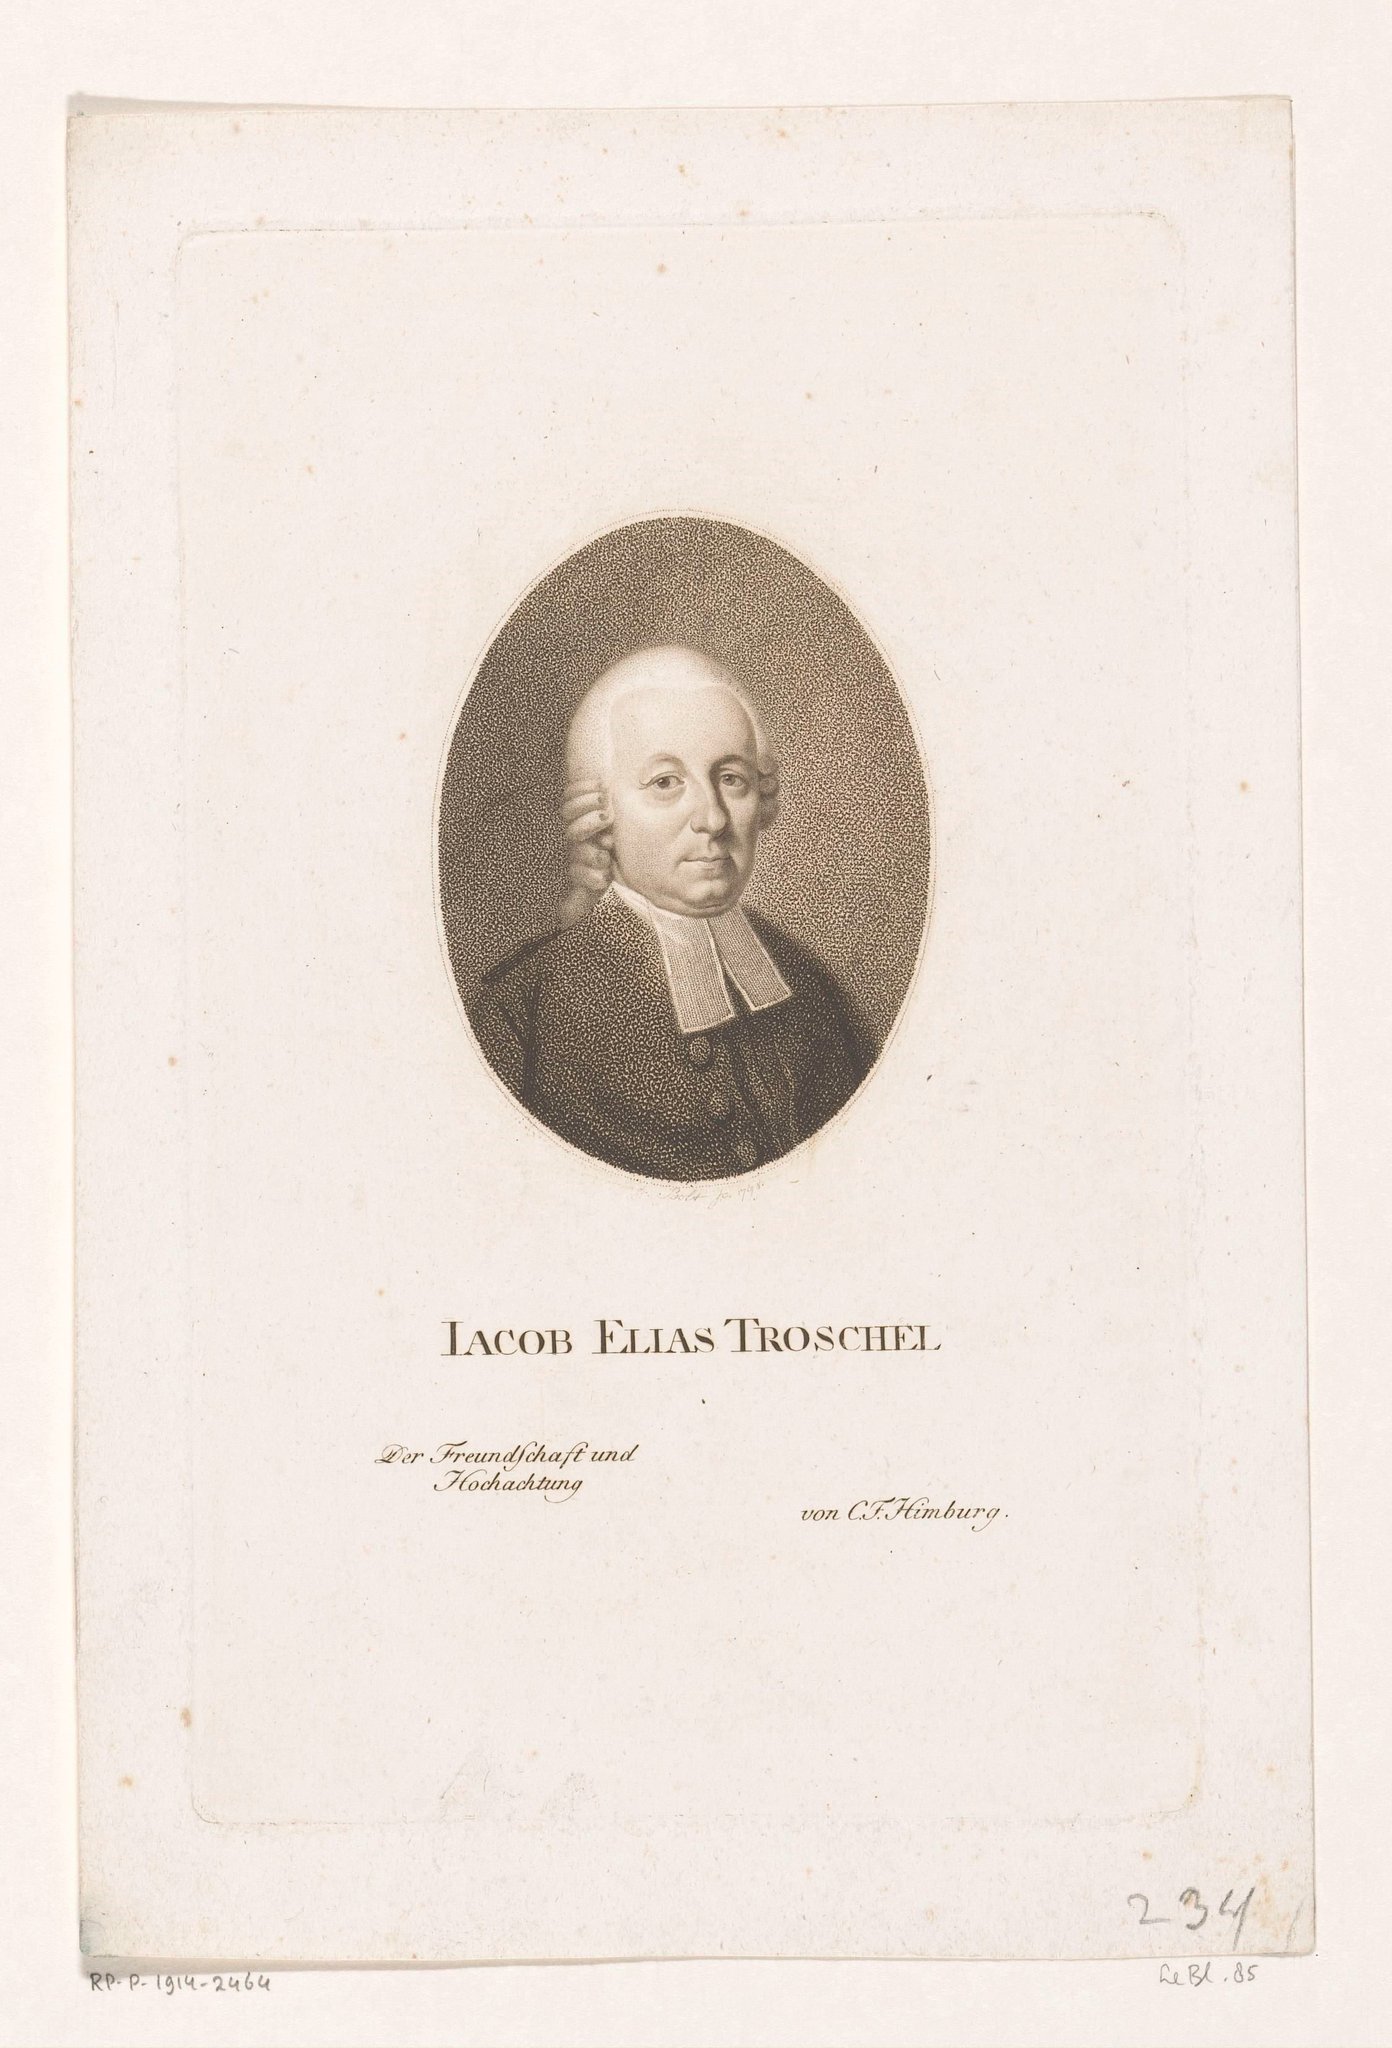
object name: print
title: Portret van Jakob Elias Troschel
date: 1798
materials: paper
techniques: stippling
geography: berlin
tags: jakob elias troschel, historical persons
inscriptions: collector's mark: Lugt 2228